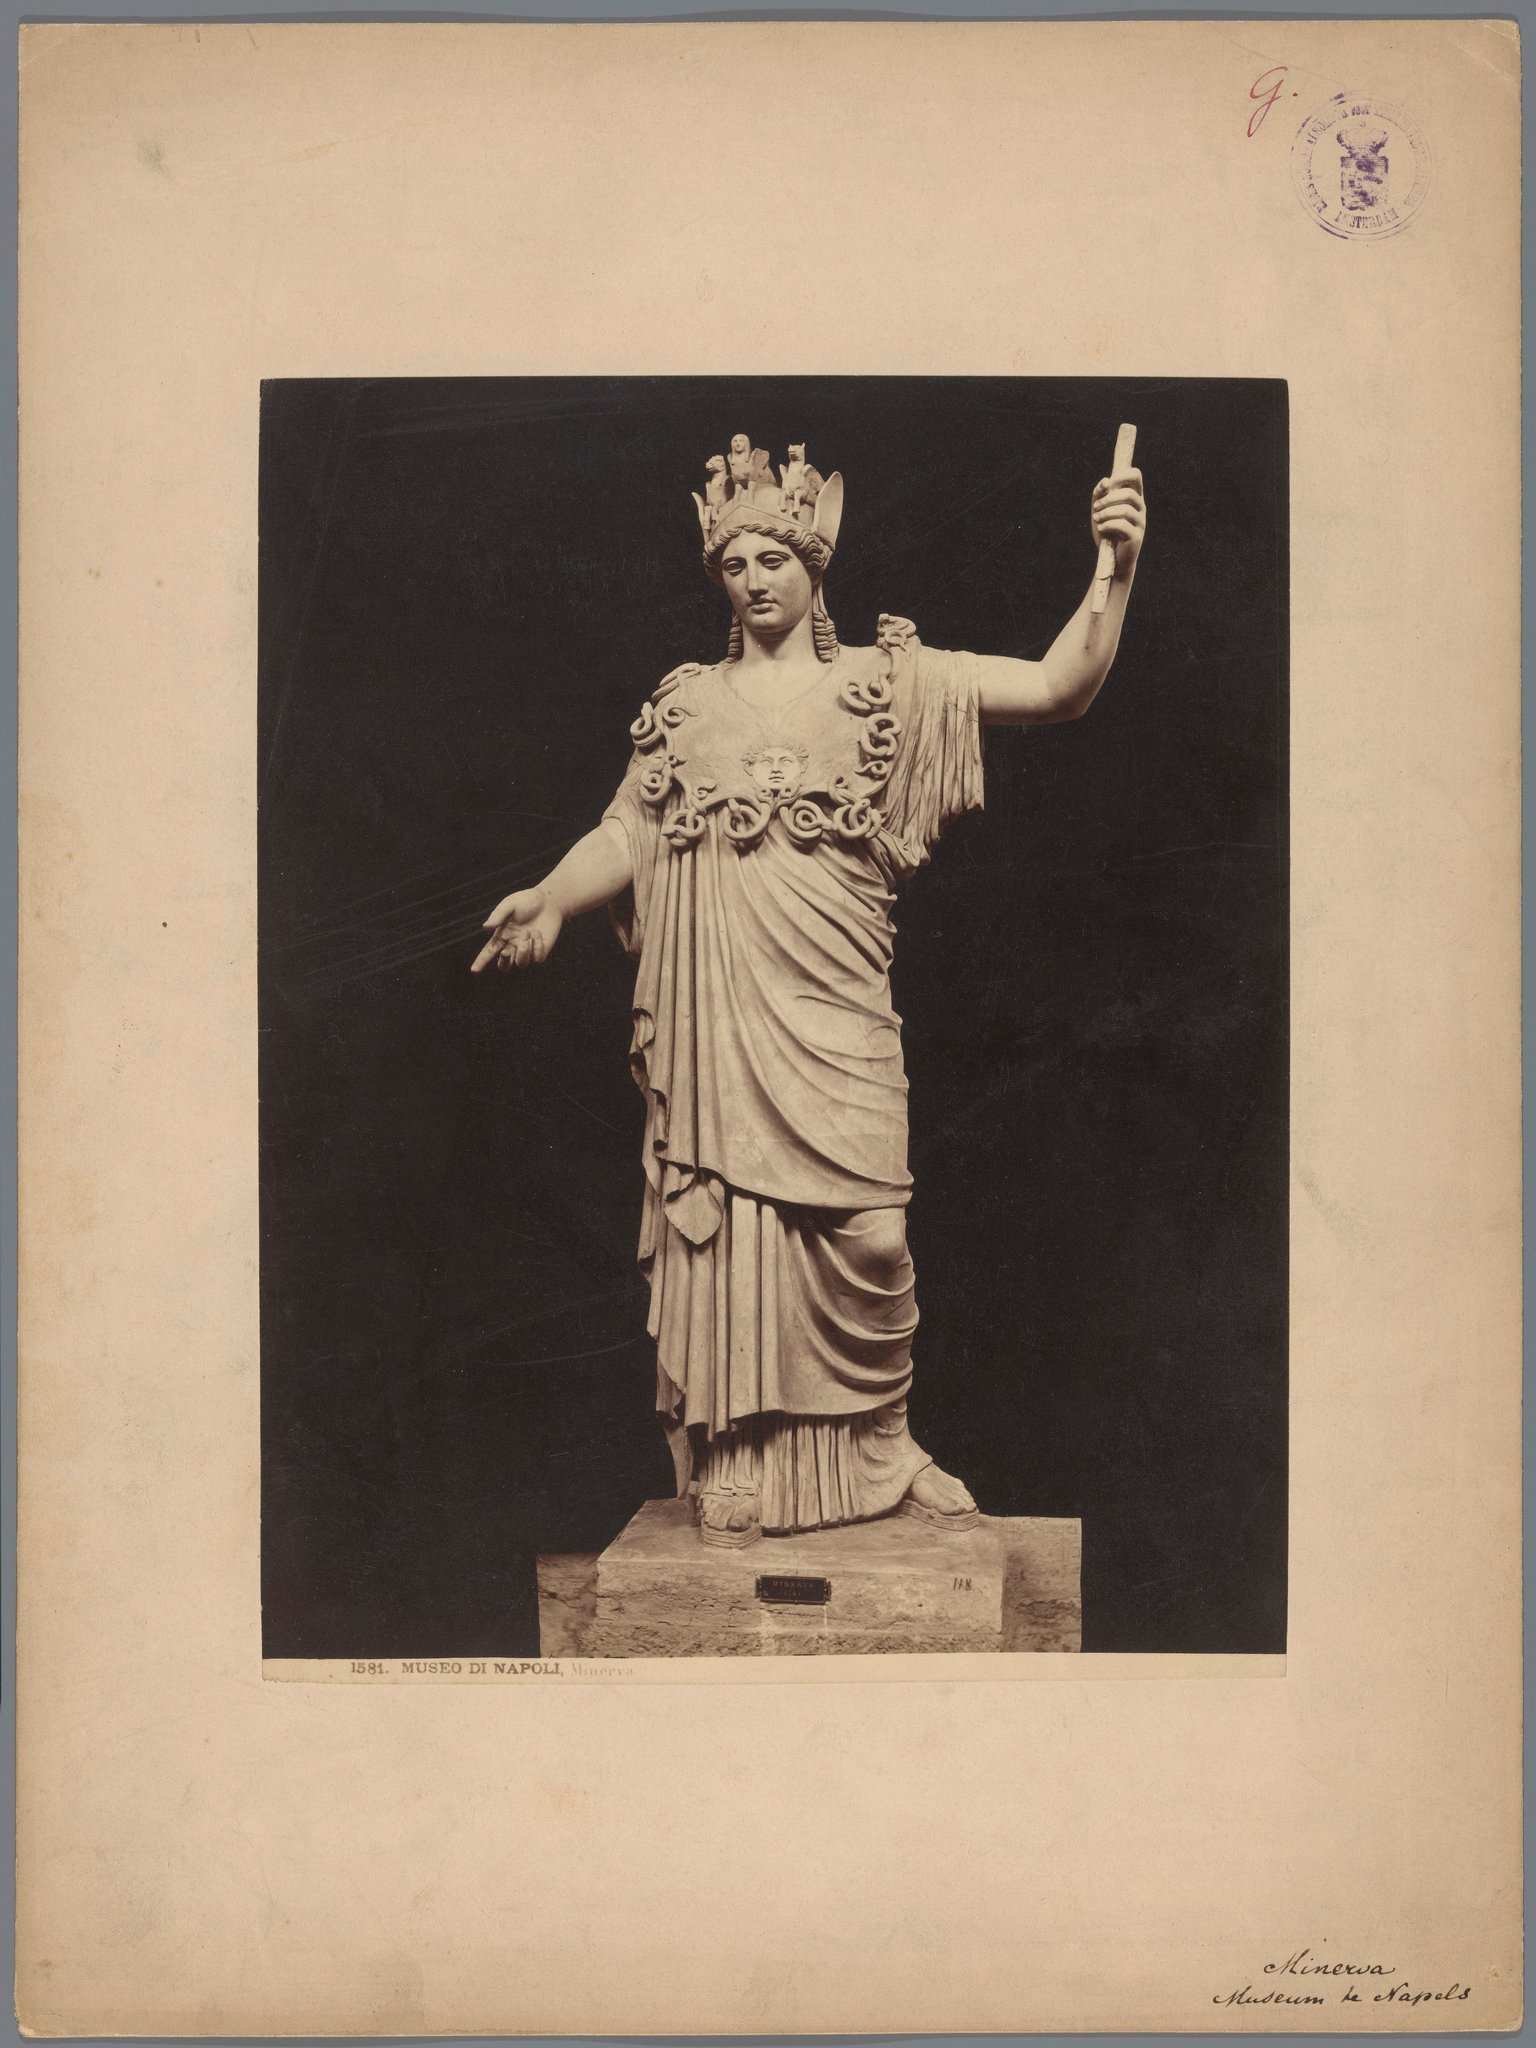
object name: photograph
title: Beeld van Minerva te Napels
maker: Anonymous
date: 1850-1900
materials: cardboard, photographic support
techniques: albumen print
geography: naples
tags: (story of) minerva (pallas, athena)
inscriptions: inscription: ‘Minerva/ Museum te Napels’, number: ‘1582. Museo di Napoli’, inscription: ‘G.’, collector's mark: ‘Rijks normaalschool voor teekenonderwijzers Amsterdam’